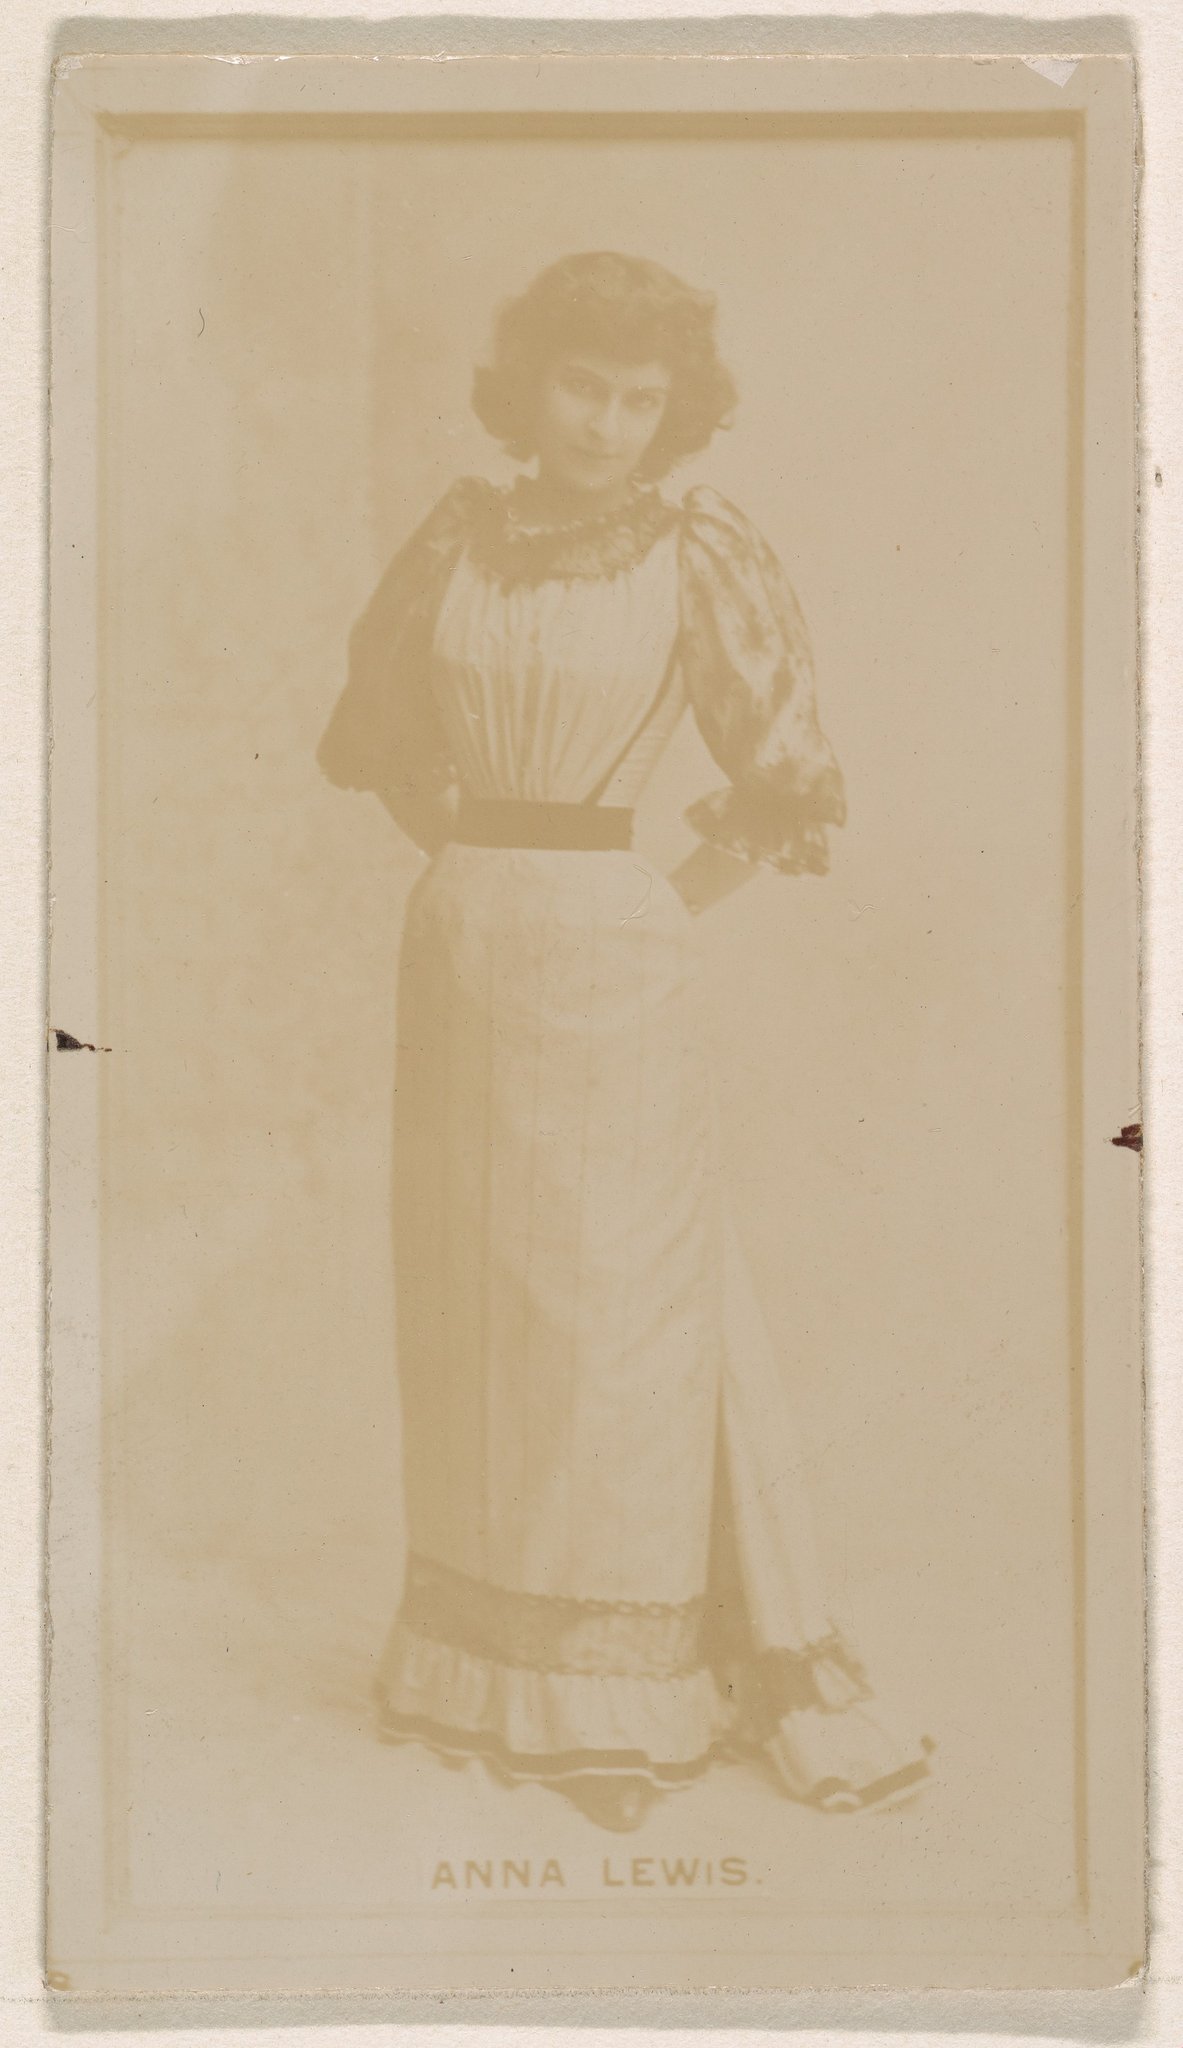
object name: photograph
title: Anna Lewis, from the Actresses series (N245) issued by Kinney Brothers to promote Sweet Caporal Cigarettes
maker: kinney brothers tobacco company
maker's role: publisher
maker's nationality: american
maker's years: 1869-2011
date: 1890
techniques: albumen silver print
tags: portraits,women,actresses